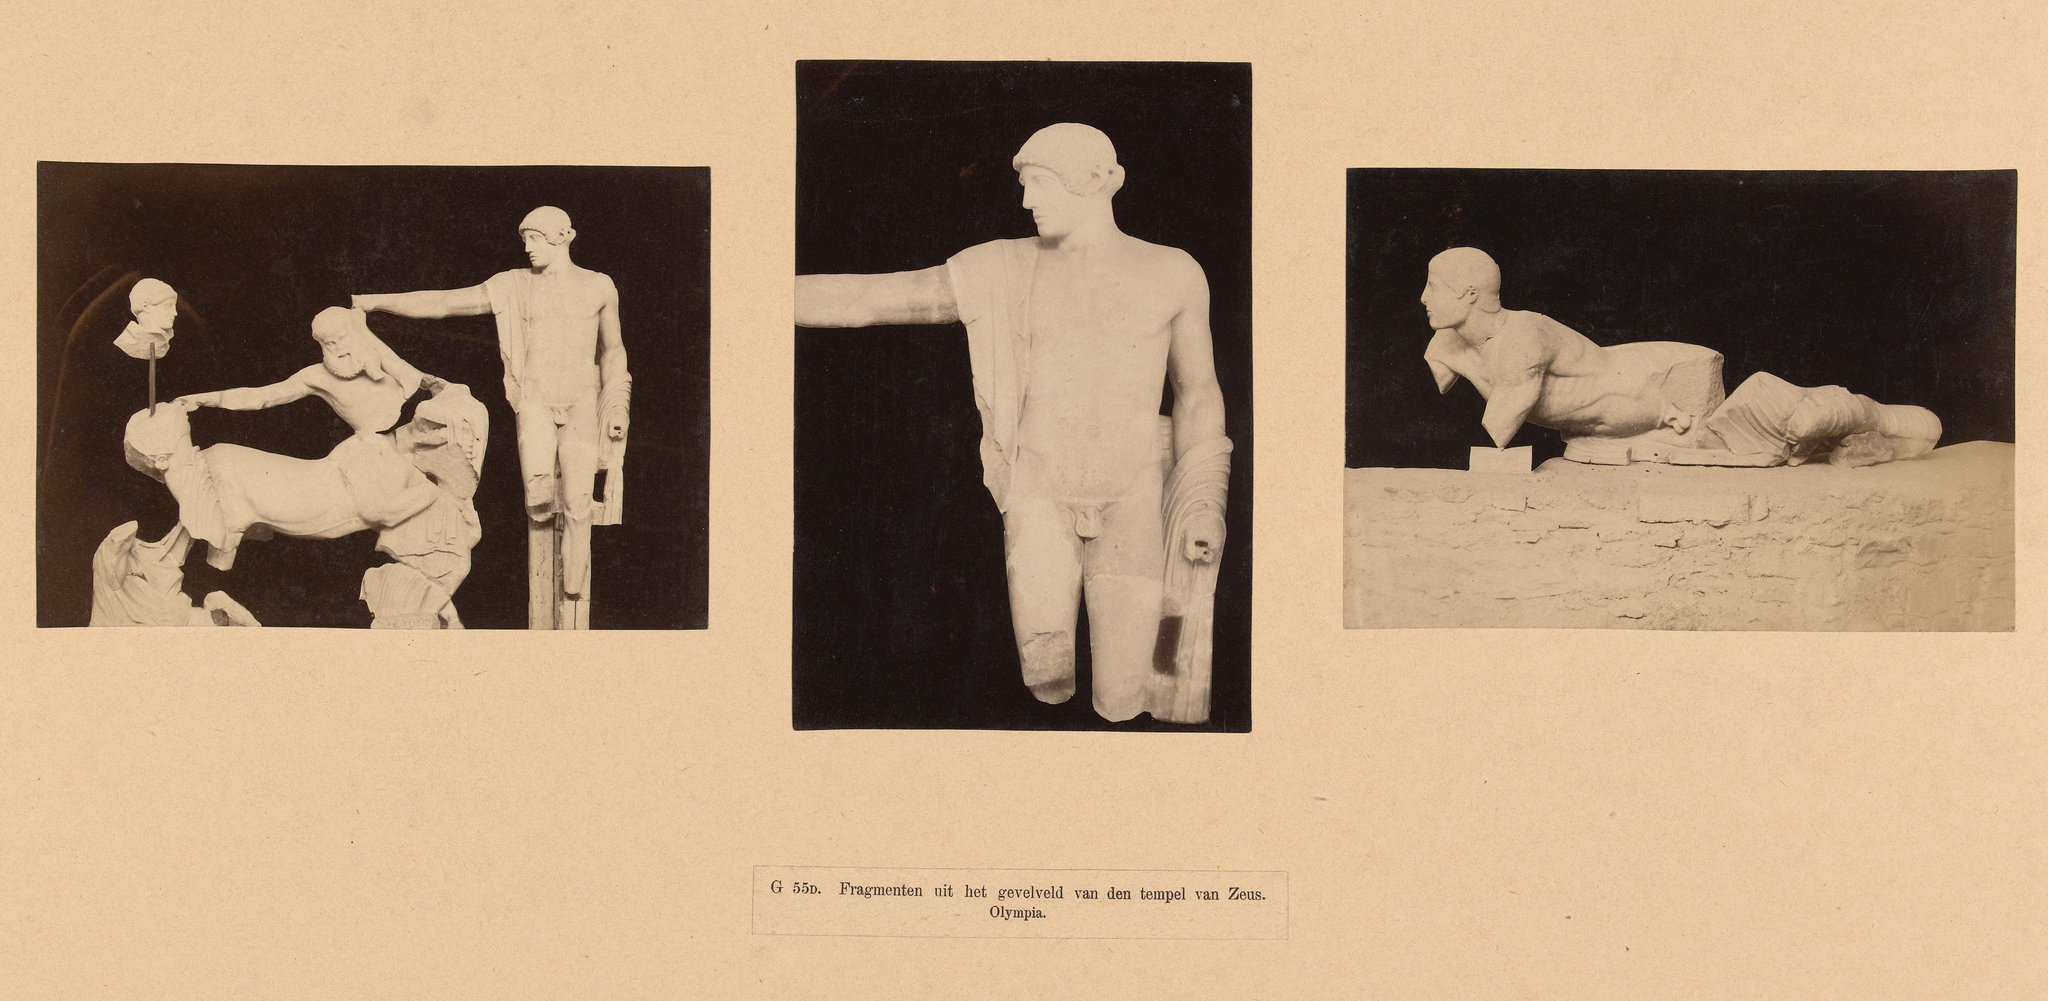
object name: photograph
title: Beeld van een Griekse man of god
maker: Anonymous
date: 1890-1895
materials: cardboard, paper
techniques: albumen print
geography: olympia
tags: piece of sculpture, reproduction of a piece of sculpture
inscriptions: stamp: ‘Gemeentelijke bibliotheek/ Rotterdam’, check stamp: ‘Bristol/ L.M.’, title: ‘G 55D. Fragmenten uit het gevelveld van den tempel van Zeus./ Olympia.’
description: Onderdeel van een groep door fotograaf Richard Polak op reis verzamelde foto’s. Deze foto is samen met andere op zijn reizen verzamelde foto's tentoongesteld bij de Rotterdamsche Kunstkring (1895), Arti en Amicitiae te Amsterdam (1897-1898?) en Societeit 't Collegie te Kampen (datum vooralsnog onbekend).